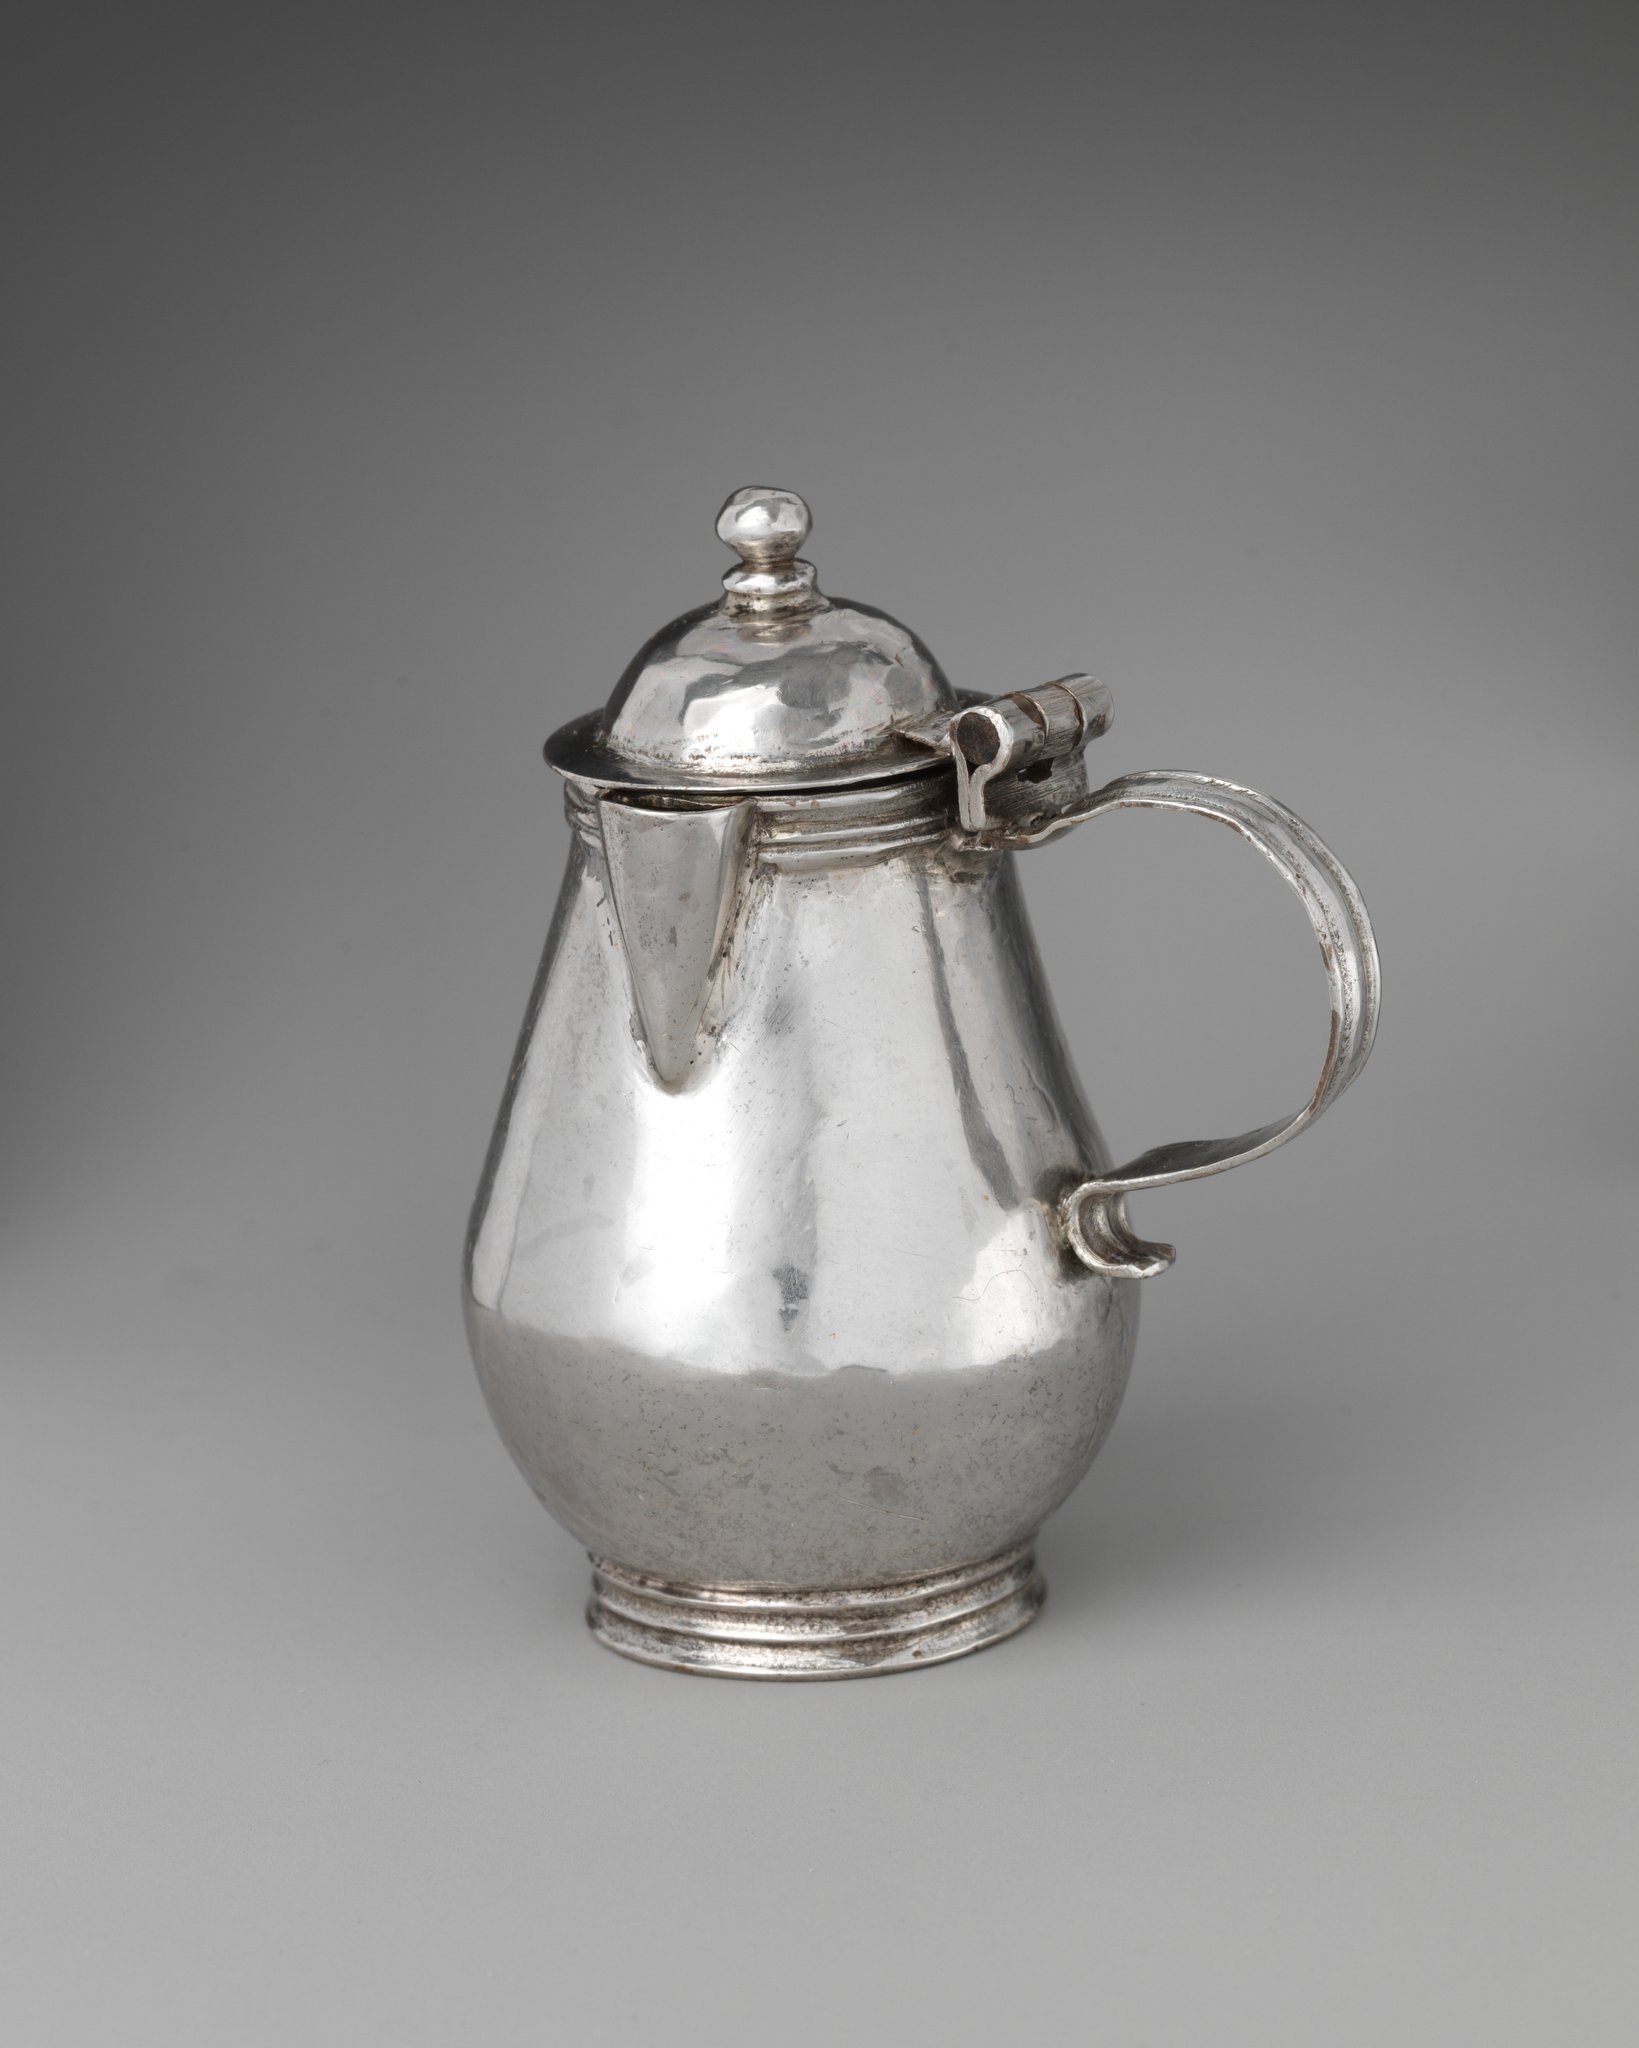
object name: jug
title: Miniature jug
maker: george manjoy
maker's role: maker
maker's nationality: british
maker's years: 1685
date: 1708-1709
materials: silver